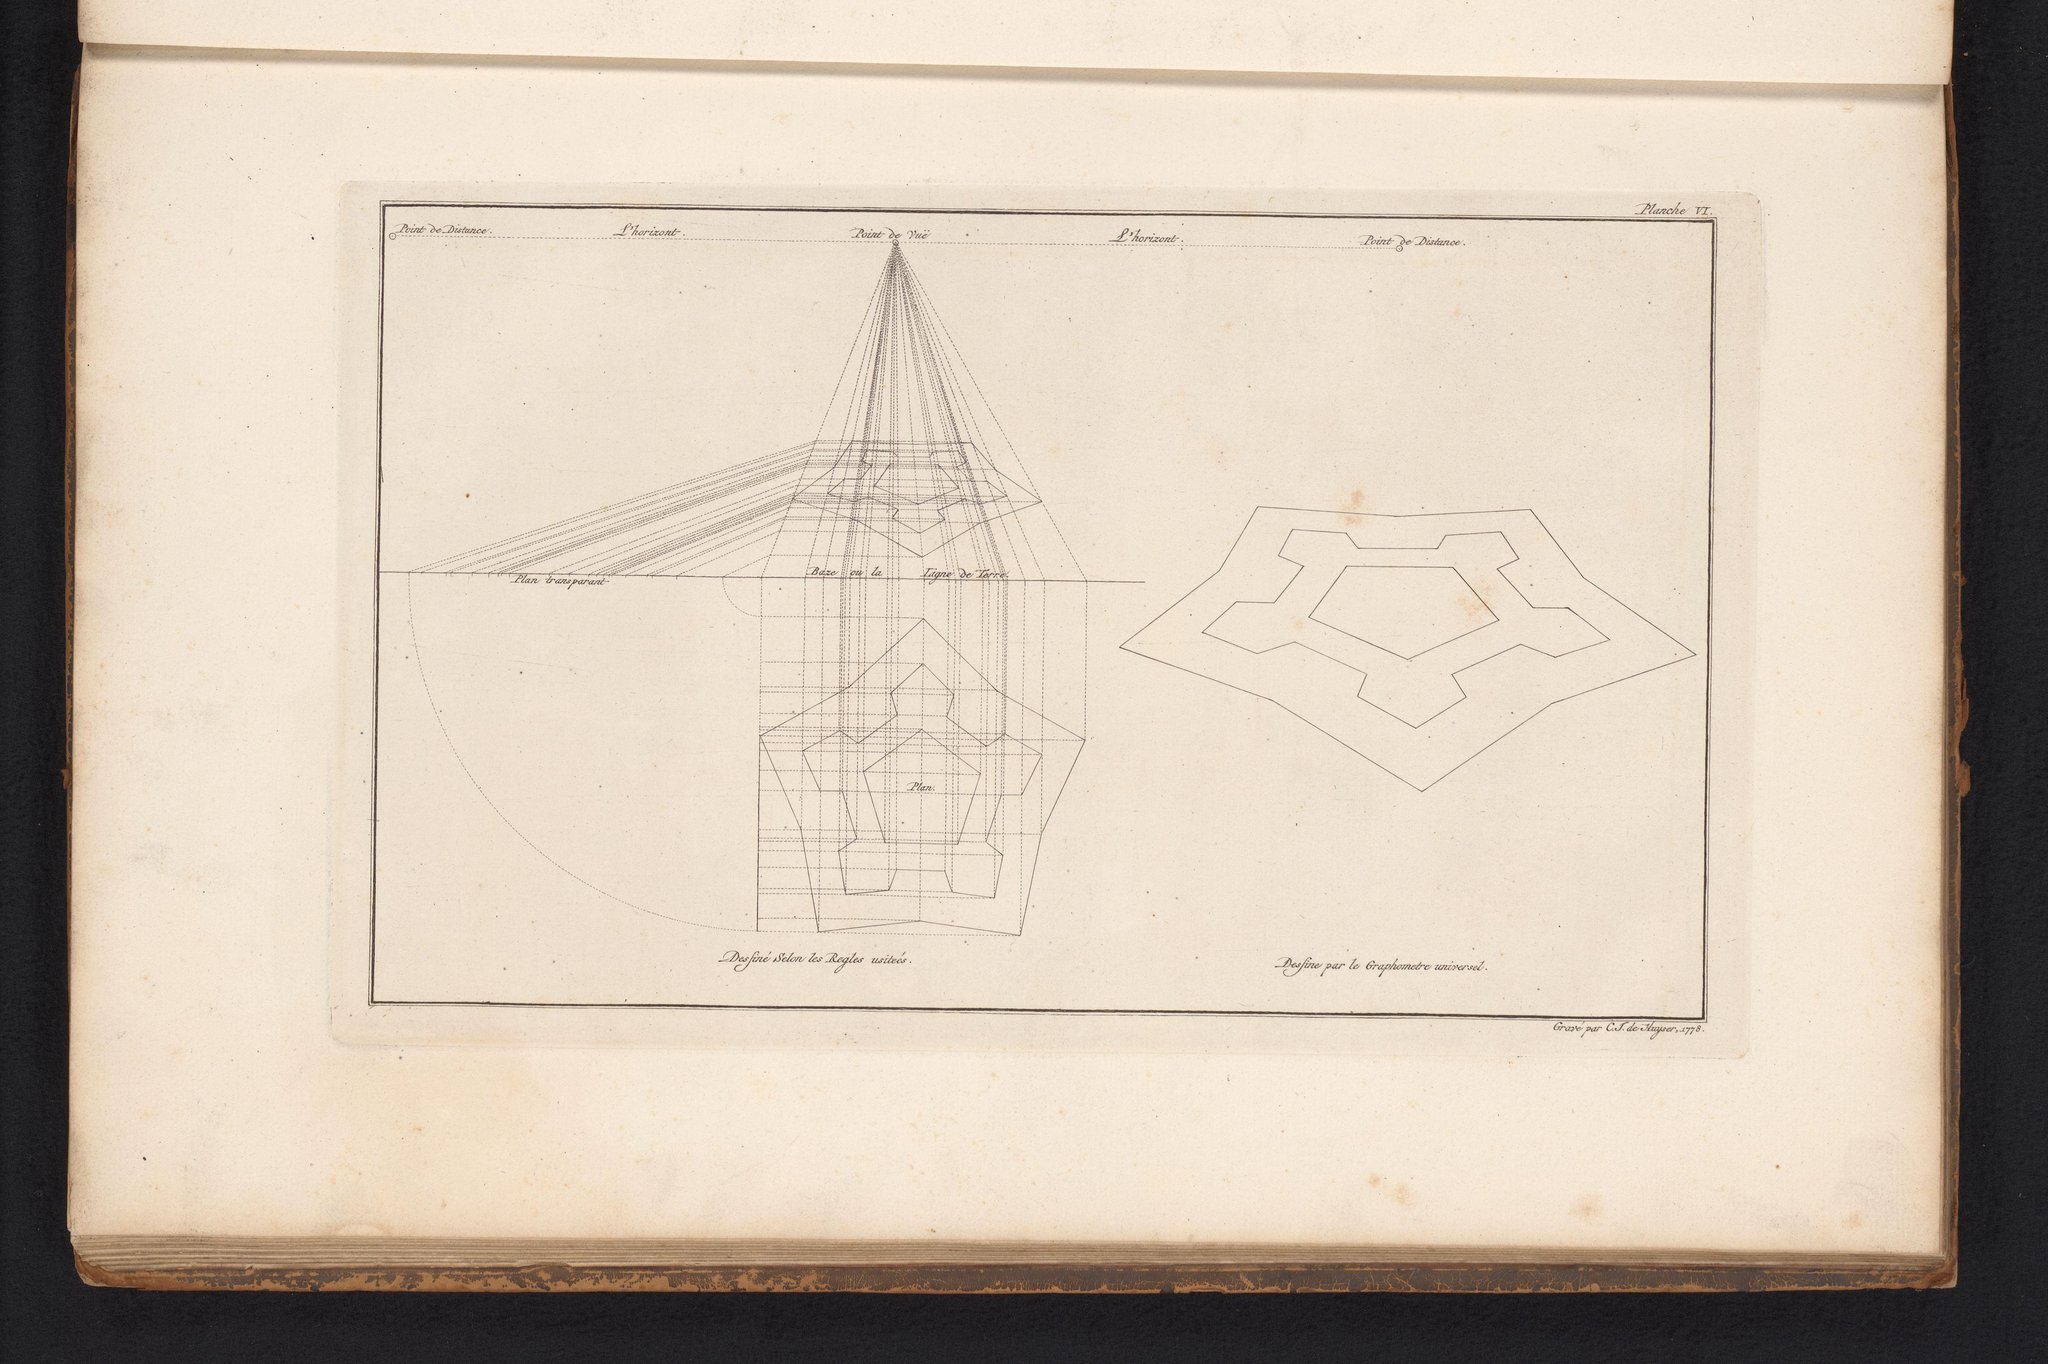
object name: album leaf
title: Beschryving van een' algemeenen graphometer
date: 1778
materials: paper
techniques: engraving, etching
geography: amsterdam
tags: instruments for perspective drawing, bastion, bulwark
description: Een geometrisch plan van een bastion, links getekend volgens de leer van het perspectief (regels der doorzichtkunde) en rechts met behulp van een grafometer. Rechtsboven gemerkt: Planche VI. De prent maakt deel uit van het boek: A.G. Eckhardt, Beschryving van een algemeenen graphometer, 1778.